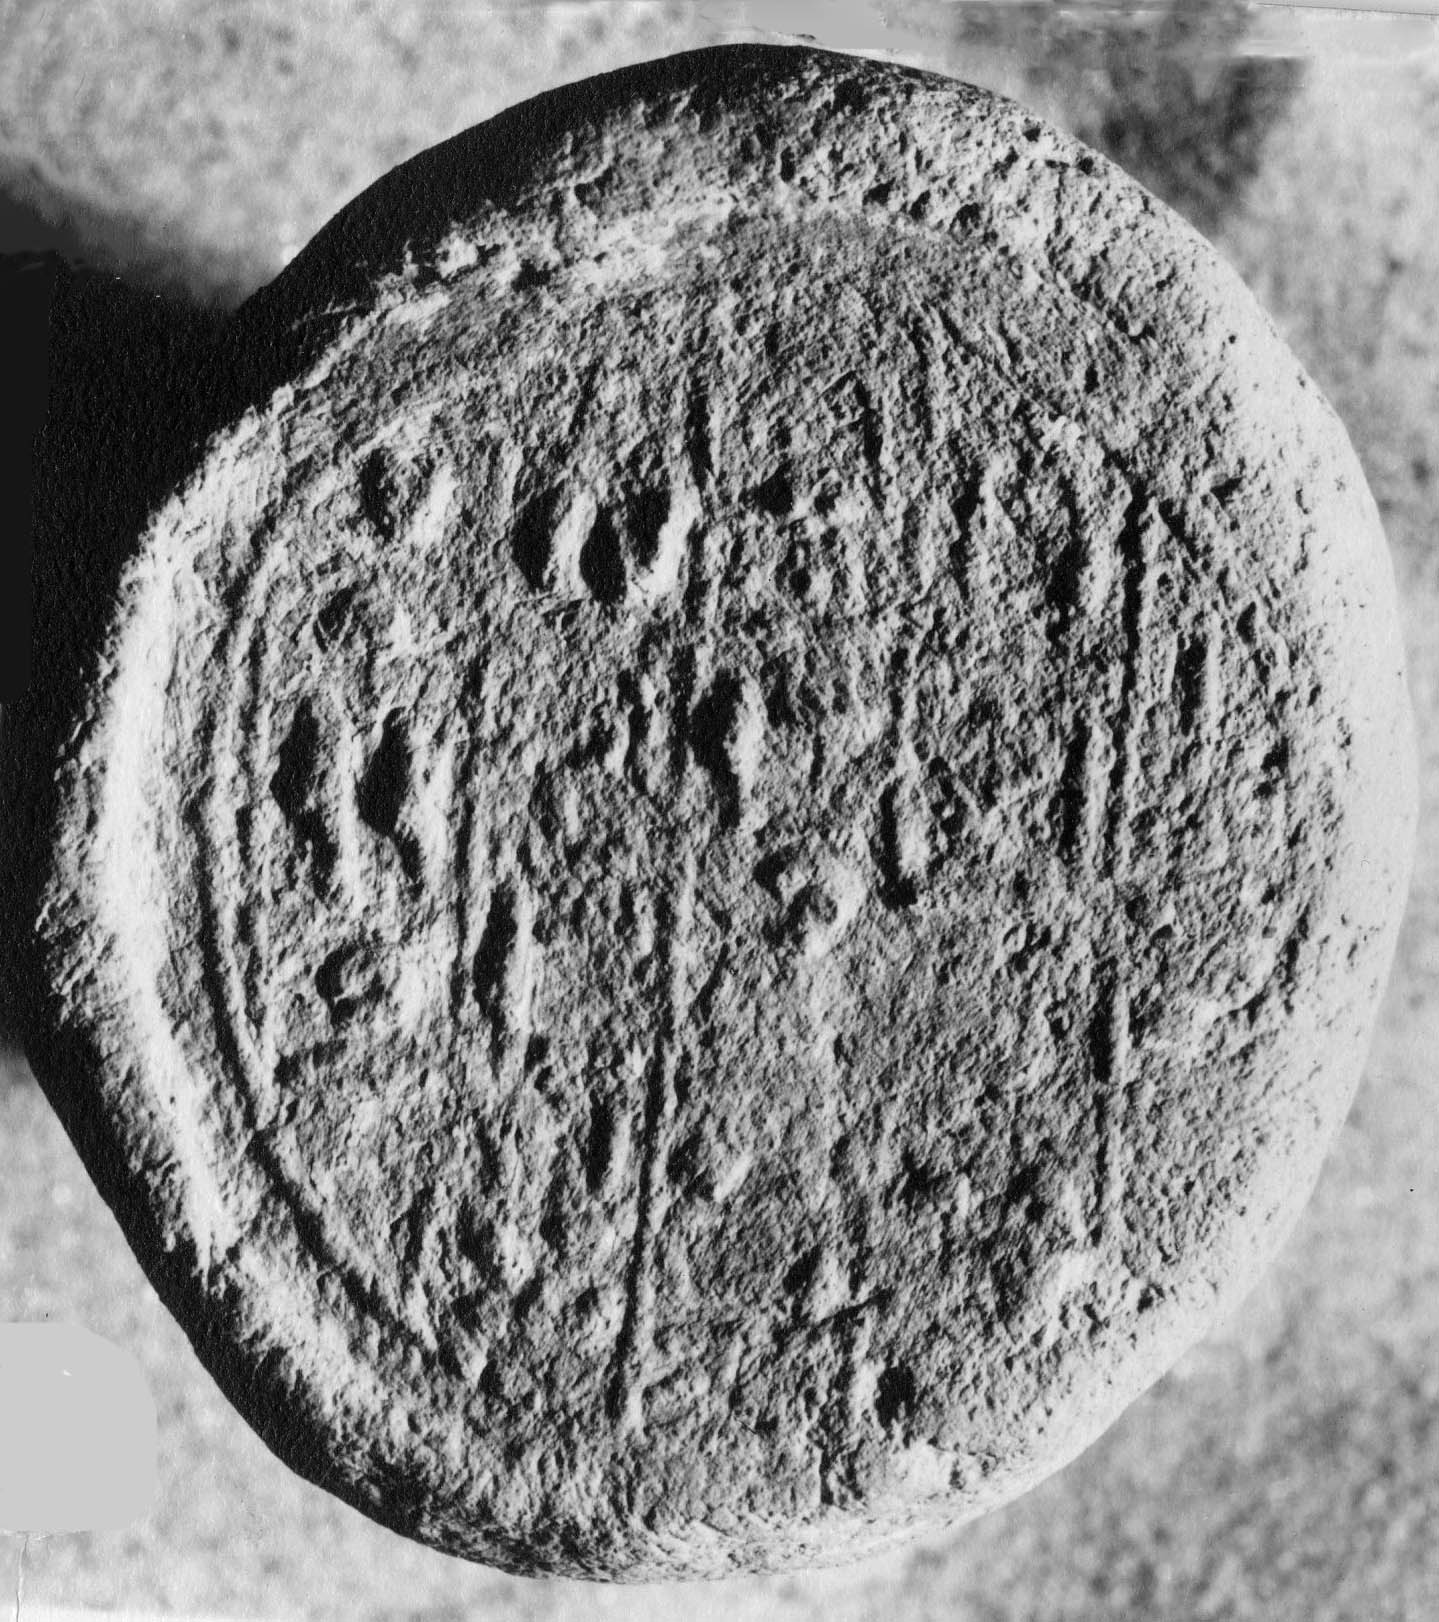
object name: cone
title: Funerary Cone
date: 1550-1295 BCE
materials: pottery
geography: egypt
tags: hieroglyphs